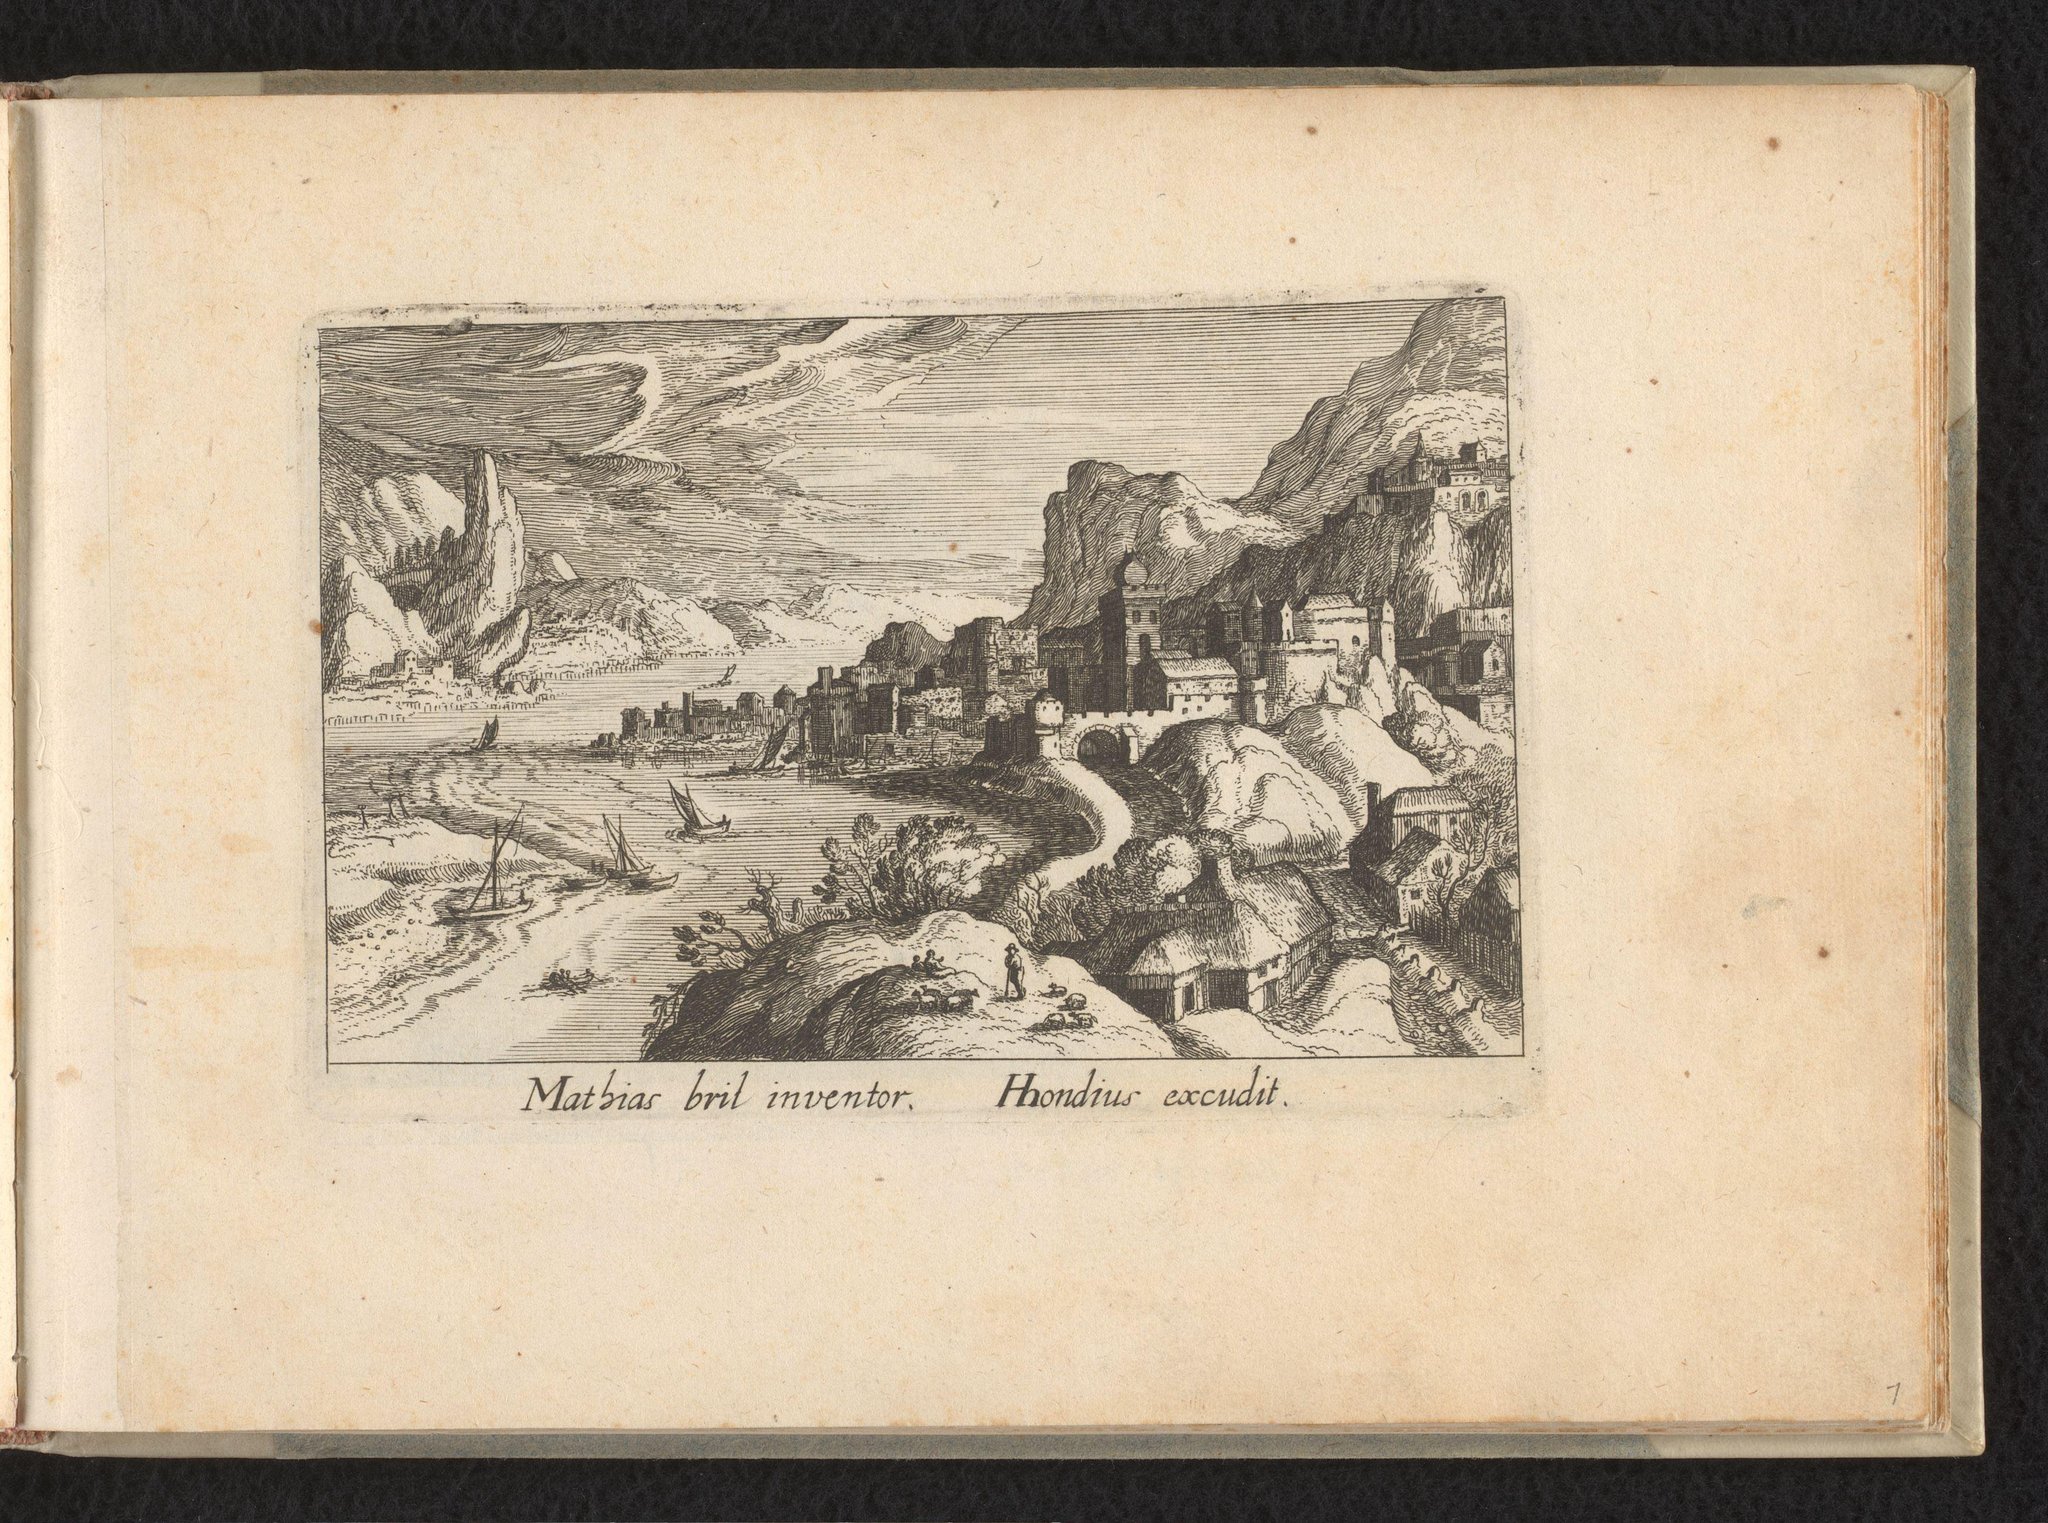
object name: print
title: Heuvellandschap met rivier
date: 1614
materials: paper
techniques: etching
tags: landscapes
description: Landschap met links een rivier waarin zeilscheepjes. Rechts heuvels met stad. Herder met kudde klein op de voorgrond